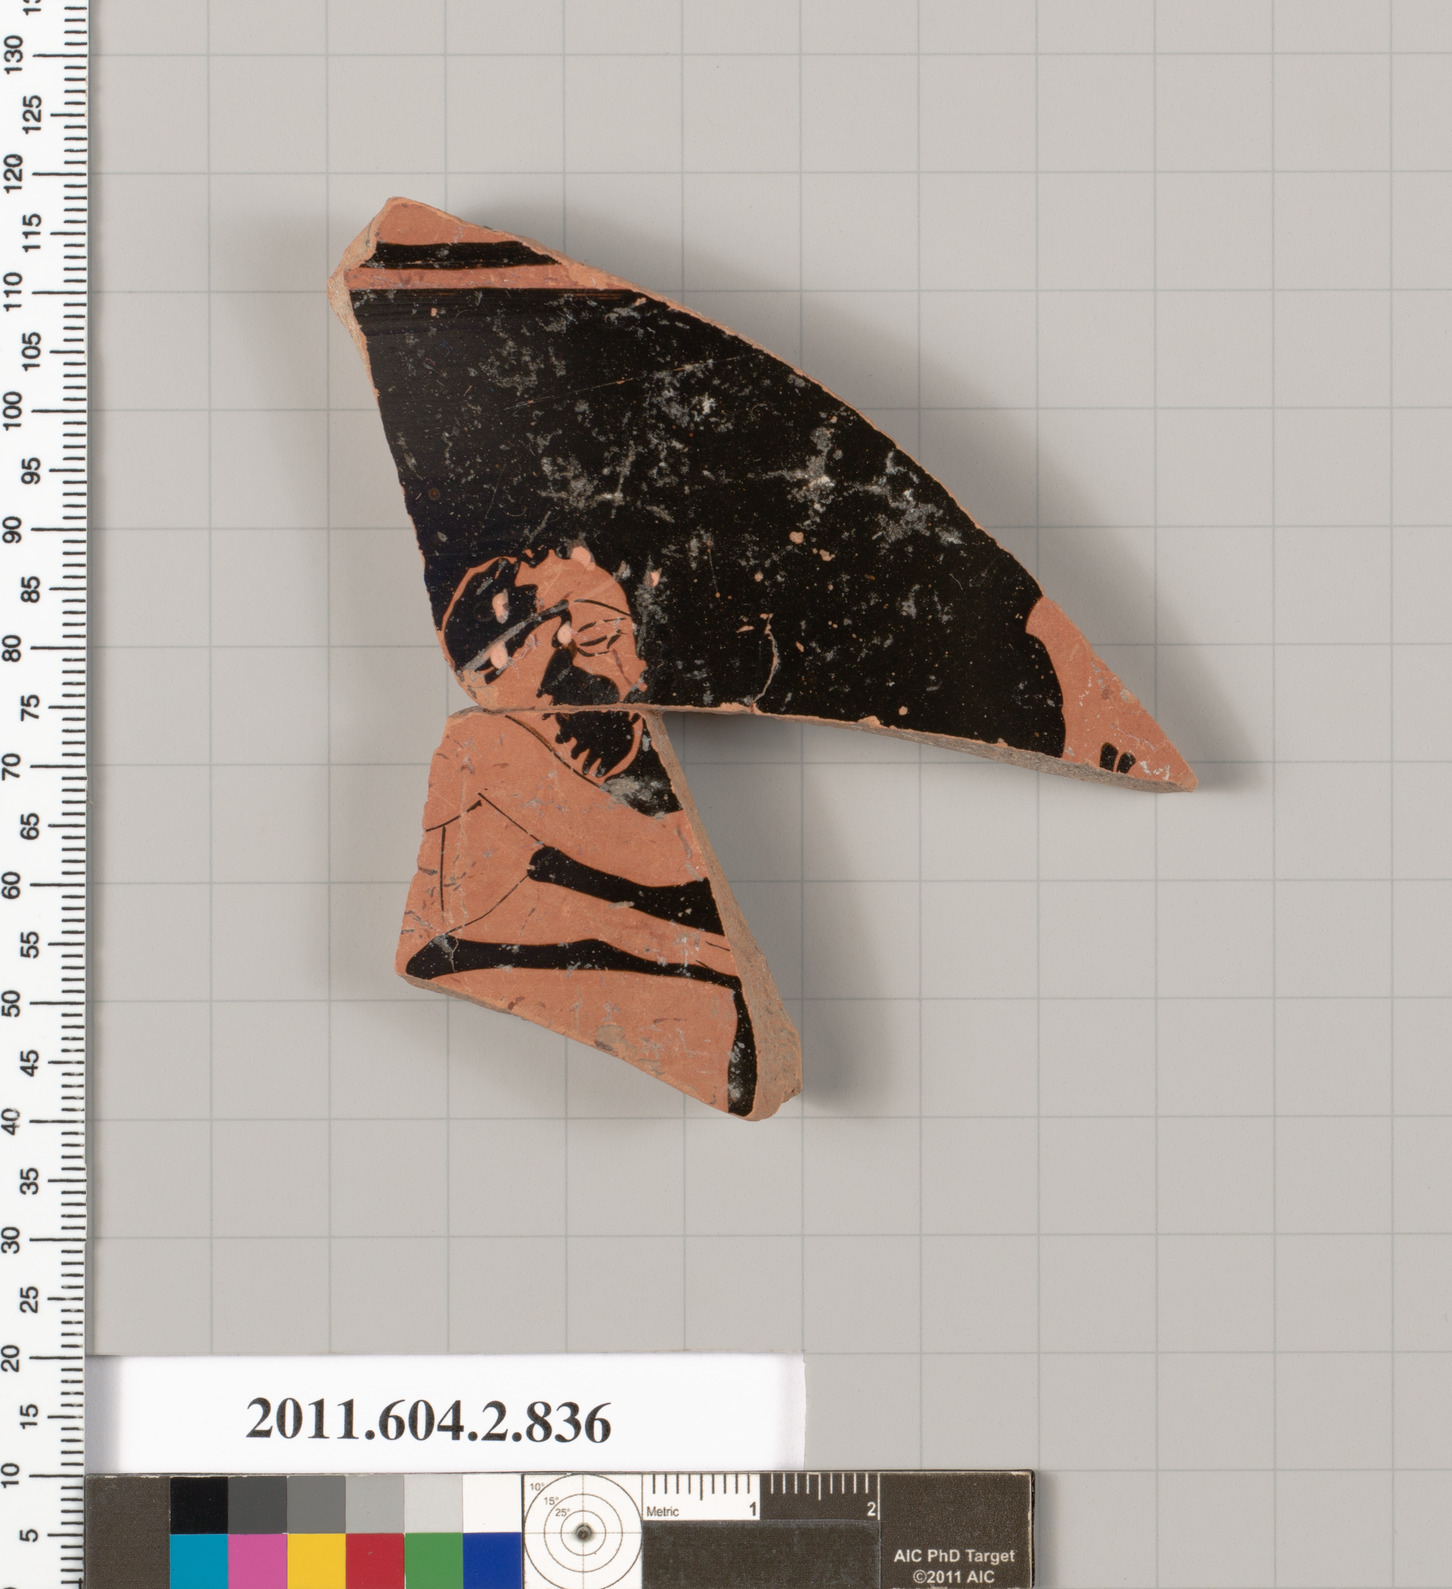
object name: bell krater fragment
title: Terracotta fragment of a bell-krater (bowl for mixing wine and water)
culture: greek, attic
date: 425-401 BCE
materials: terracotta